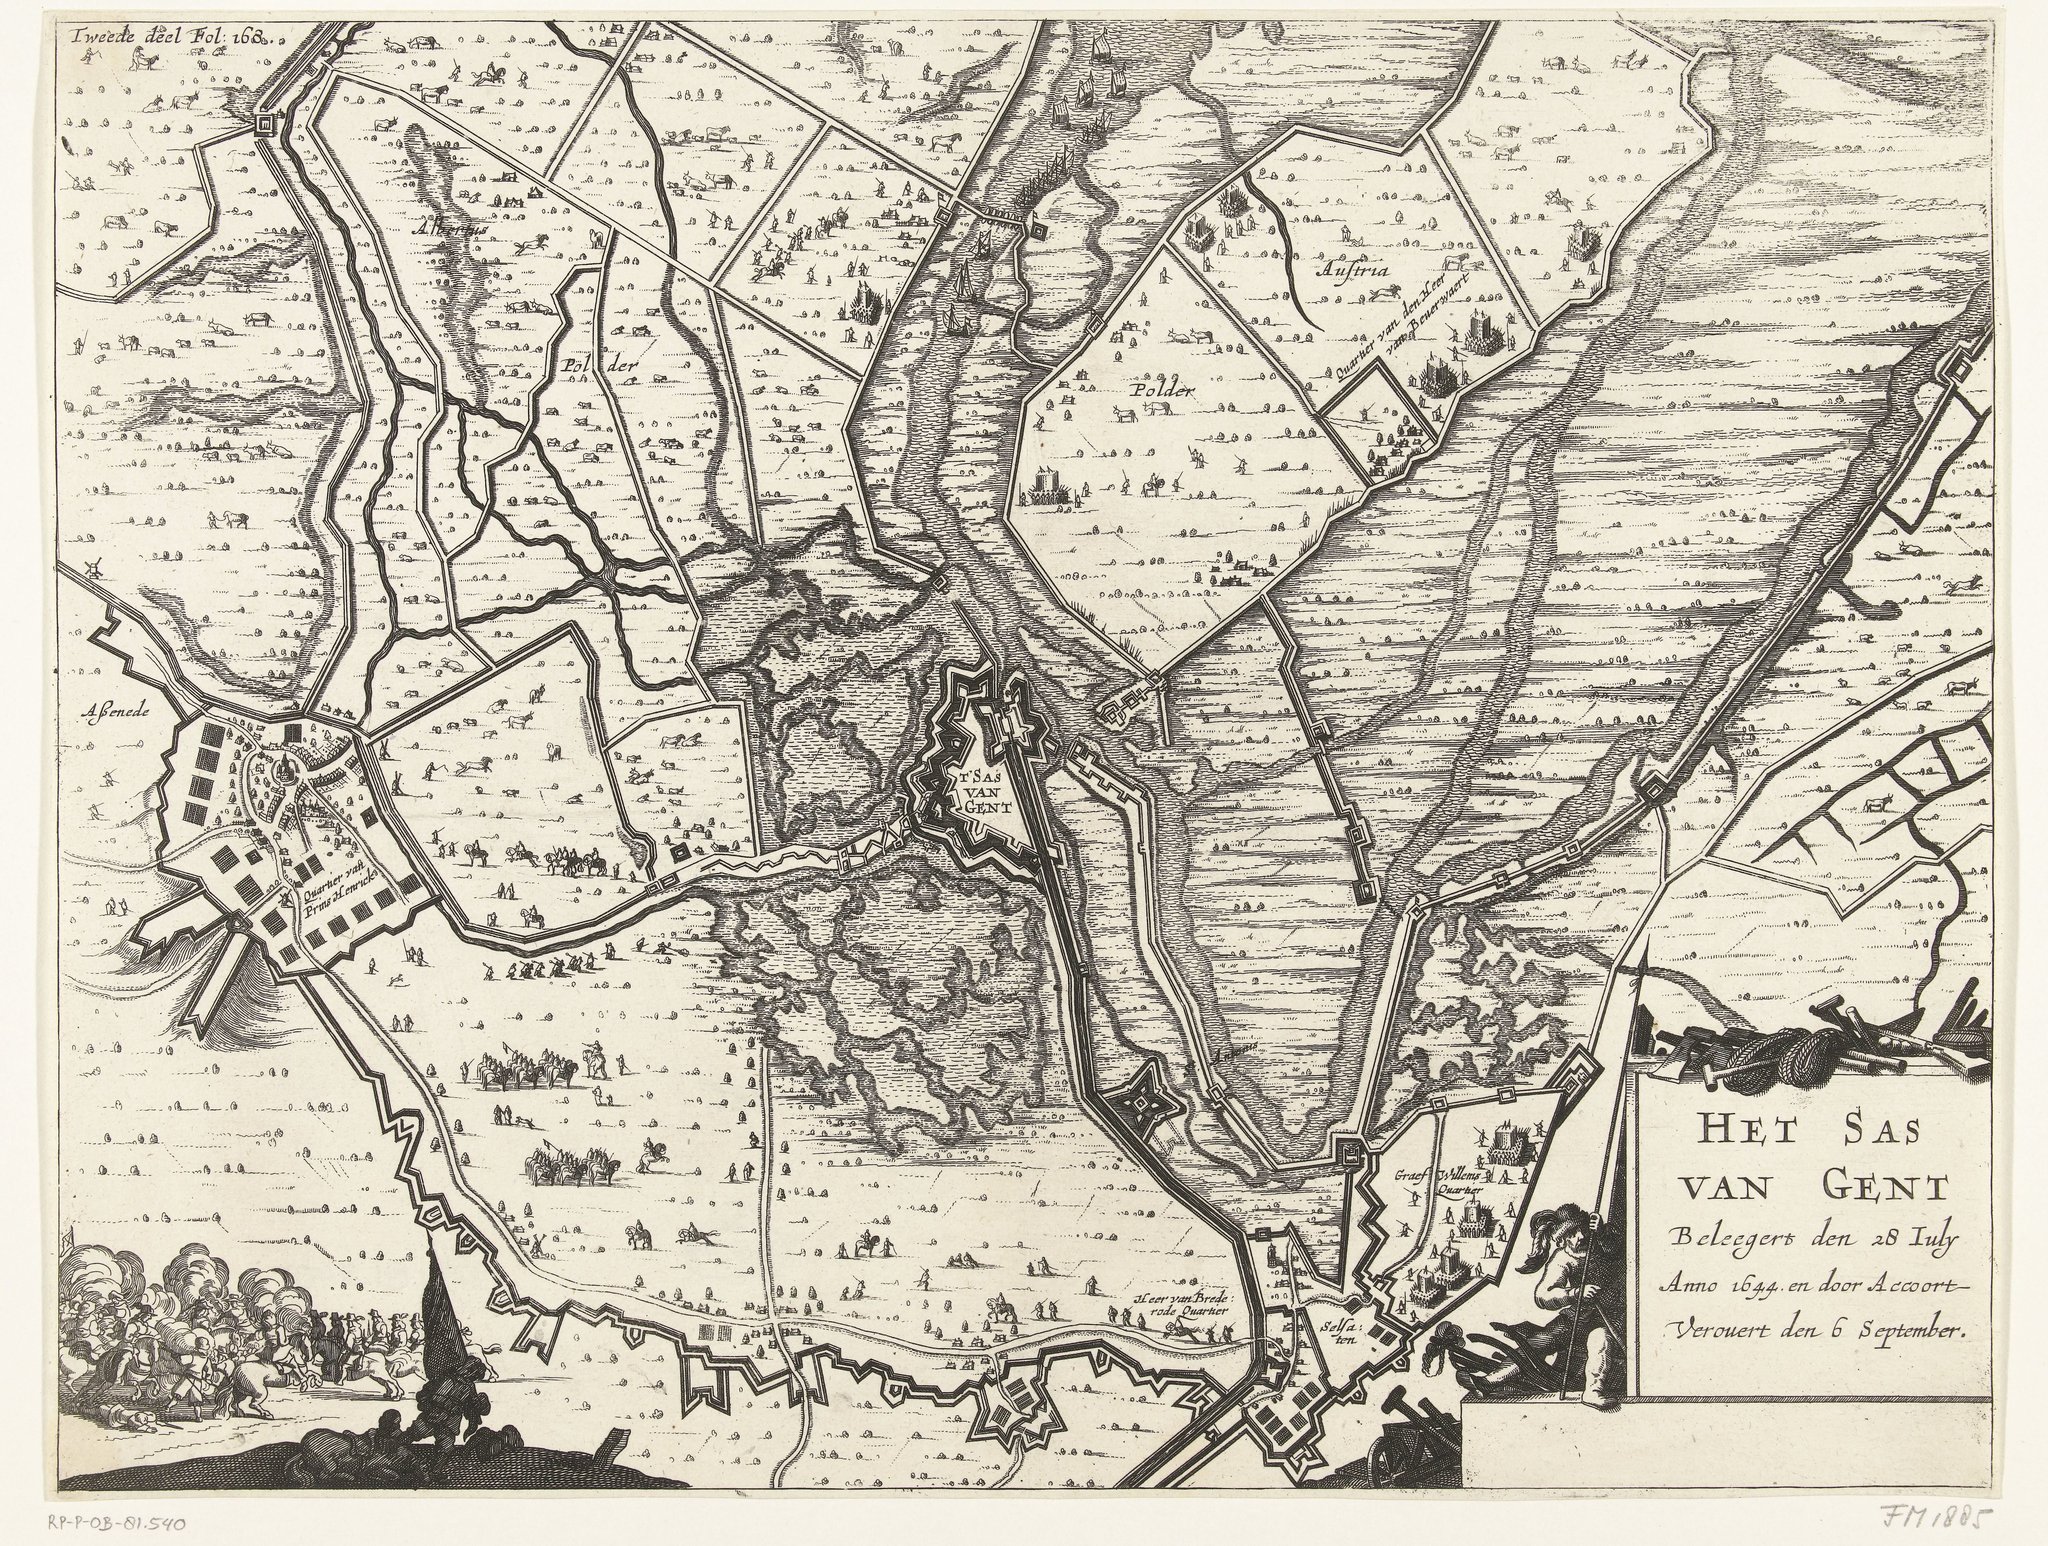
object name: map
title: Kaart van beleg en verovering van Sas-van-Gent, 1644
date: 1649-1651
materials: paper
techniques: etching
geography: amsterdam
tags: delft, the hague, frederick henry (prince of orange), maps of separate countries or regions, siege, position war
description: Kaart van het beleg van de stad Sas-van Gent door het Staatse leger onder Frederik Hendrik, begonnen 28 juli en ingenomen op 5 september 1644. Kaart van Sas-van-Gent en het omliggende land met de dijken en schansen aangelegd door de belegeraars en hun legerkampen. Rechtsonder een cartouche met de titel. Linksonder een schermutseling. Gemerkt linksboven: Tweede deel Fol: 168